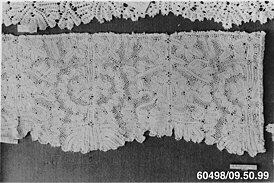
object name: strip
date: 1701-1800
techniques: lace